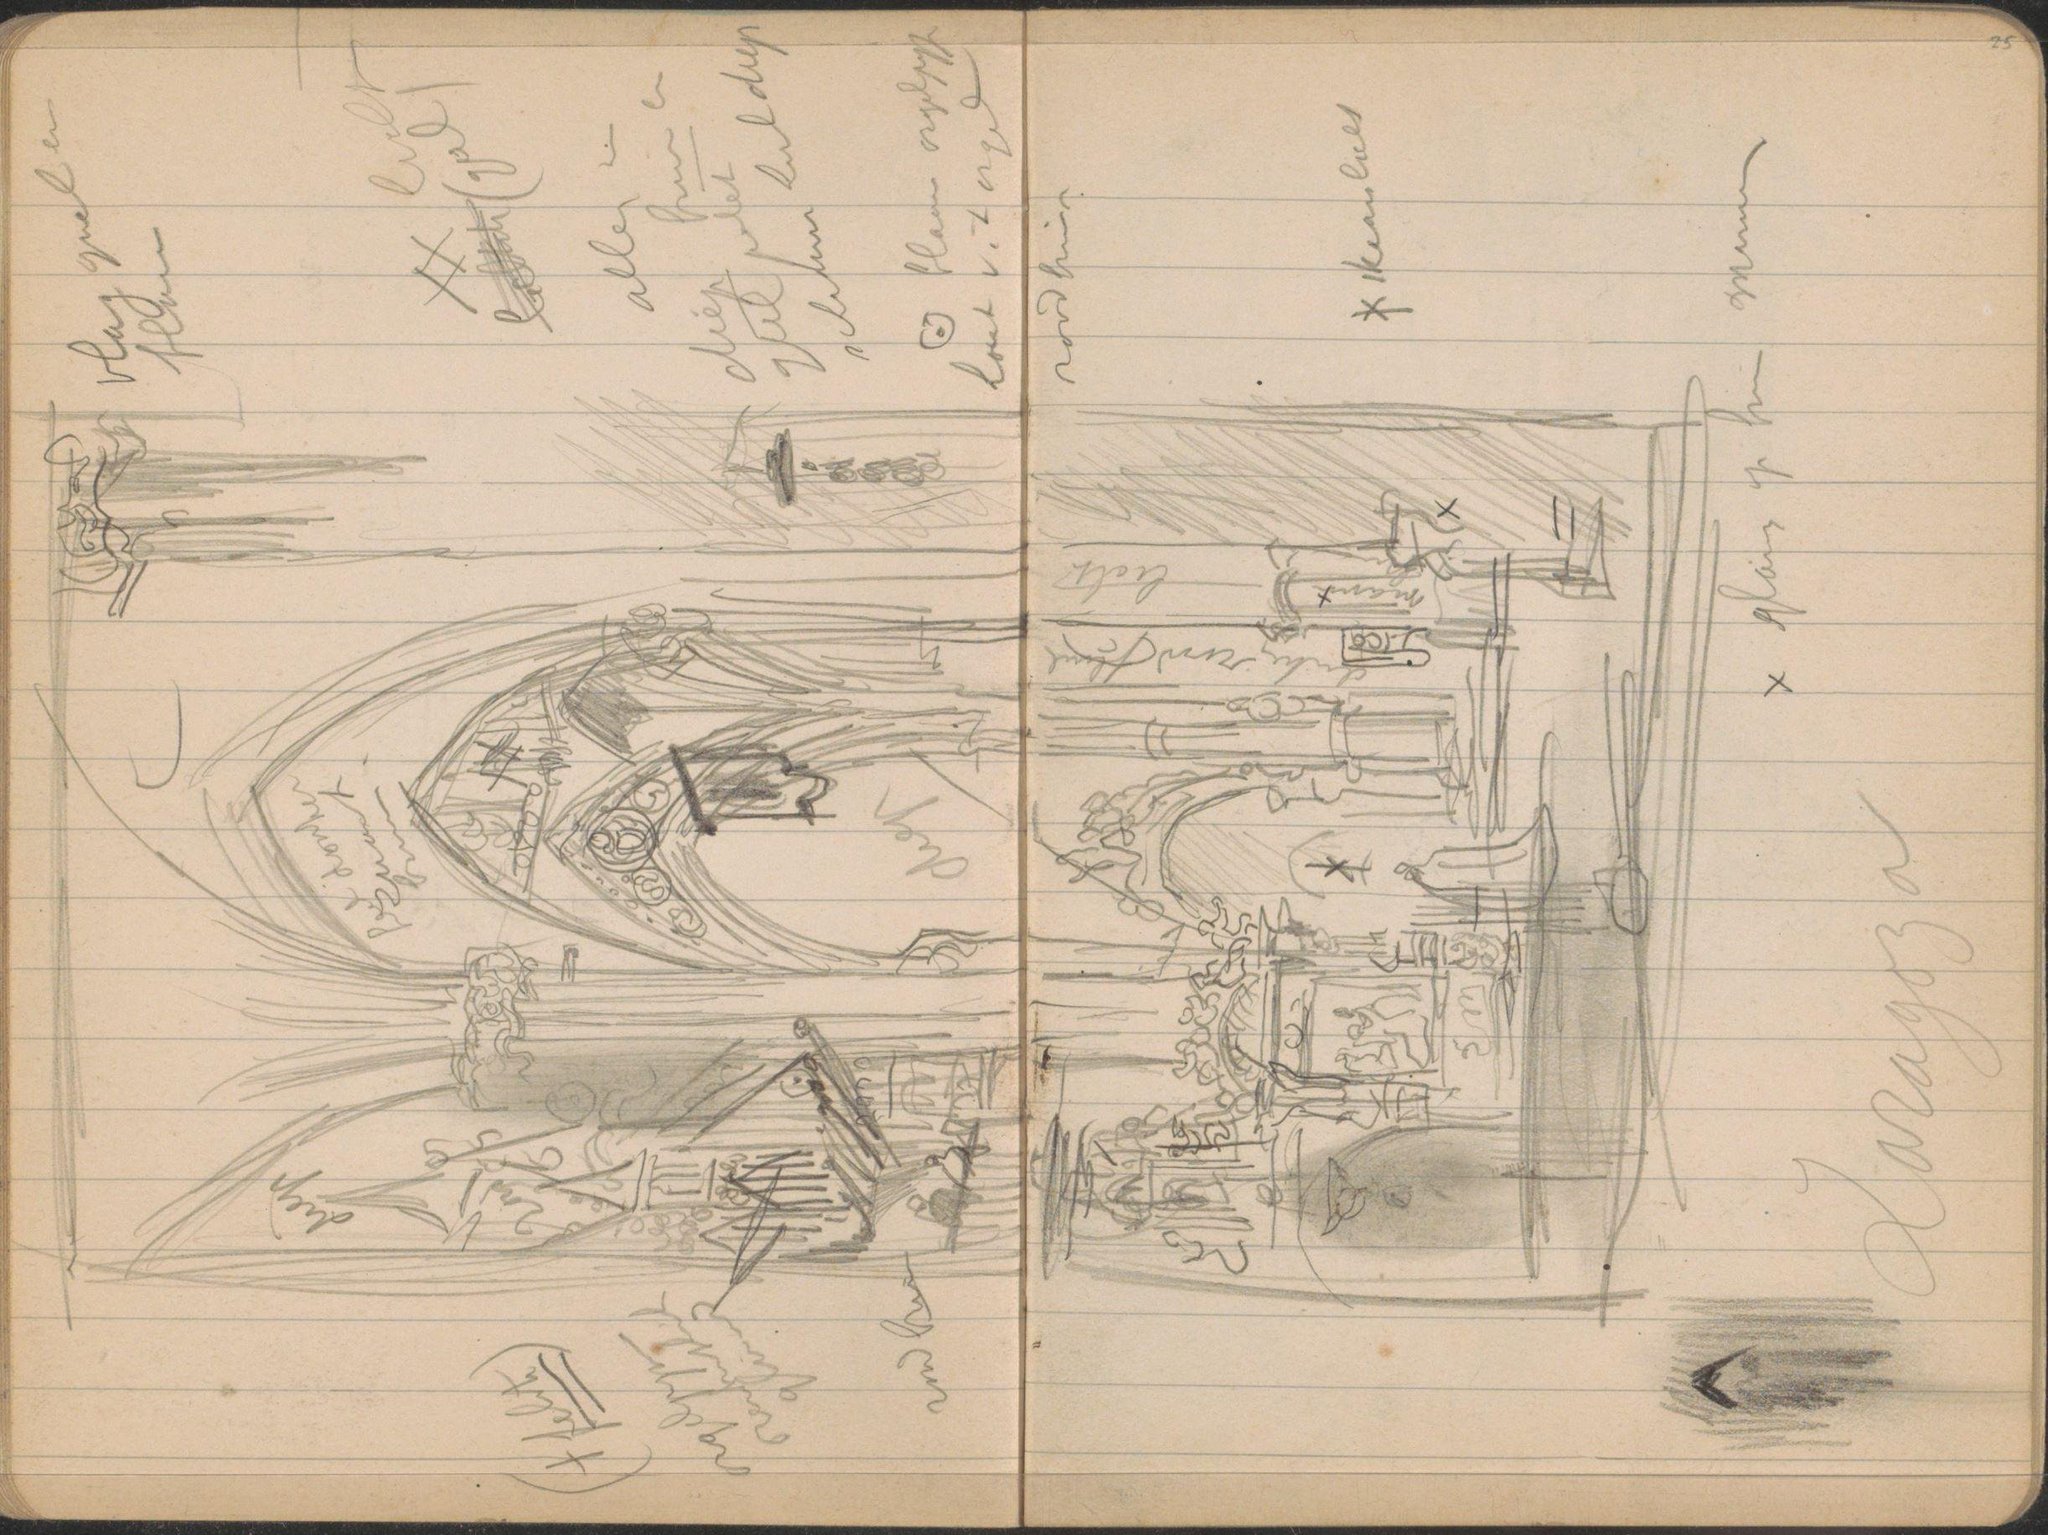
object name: sketchbook leaf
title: Interieur van de La Seo kathedraal in Zaragoza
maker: marius bauer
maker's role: draughtsman, print maker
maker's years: 1867-1932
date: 1902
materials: pencil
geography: zaragoza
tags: interior of church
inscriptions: annotation: ‘Zaragoza’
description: Pagina 24 en 25 uit een schetsboek met 50 bladen.